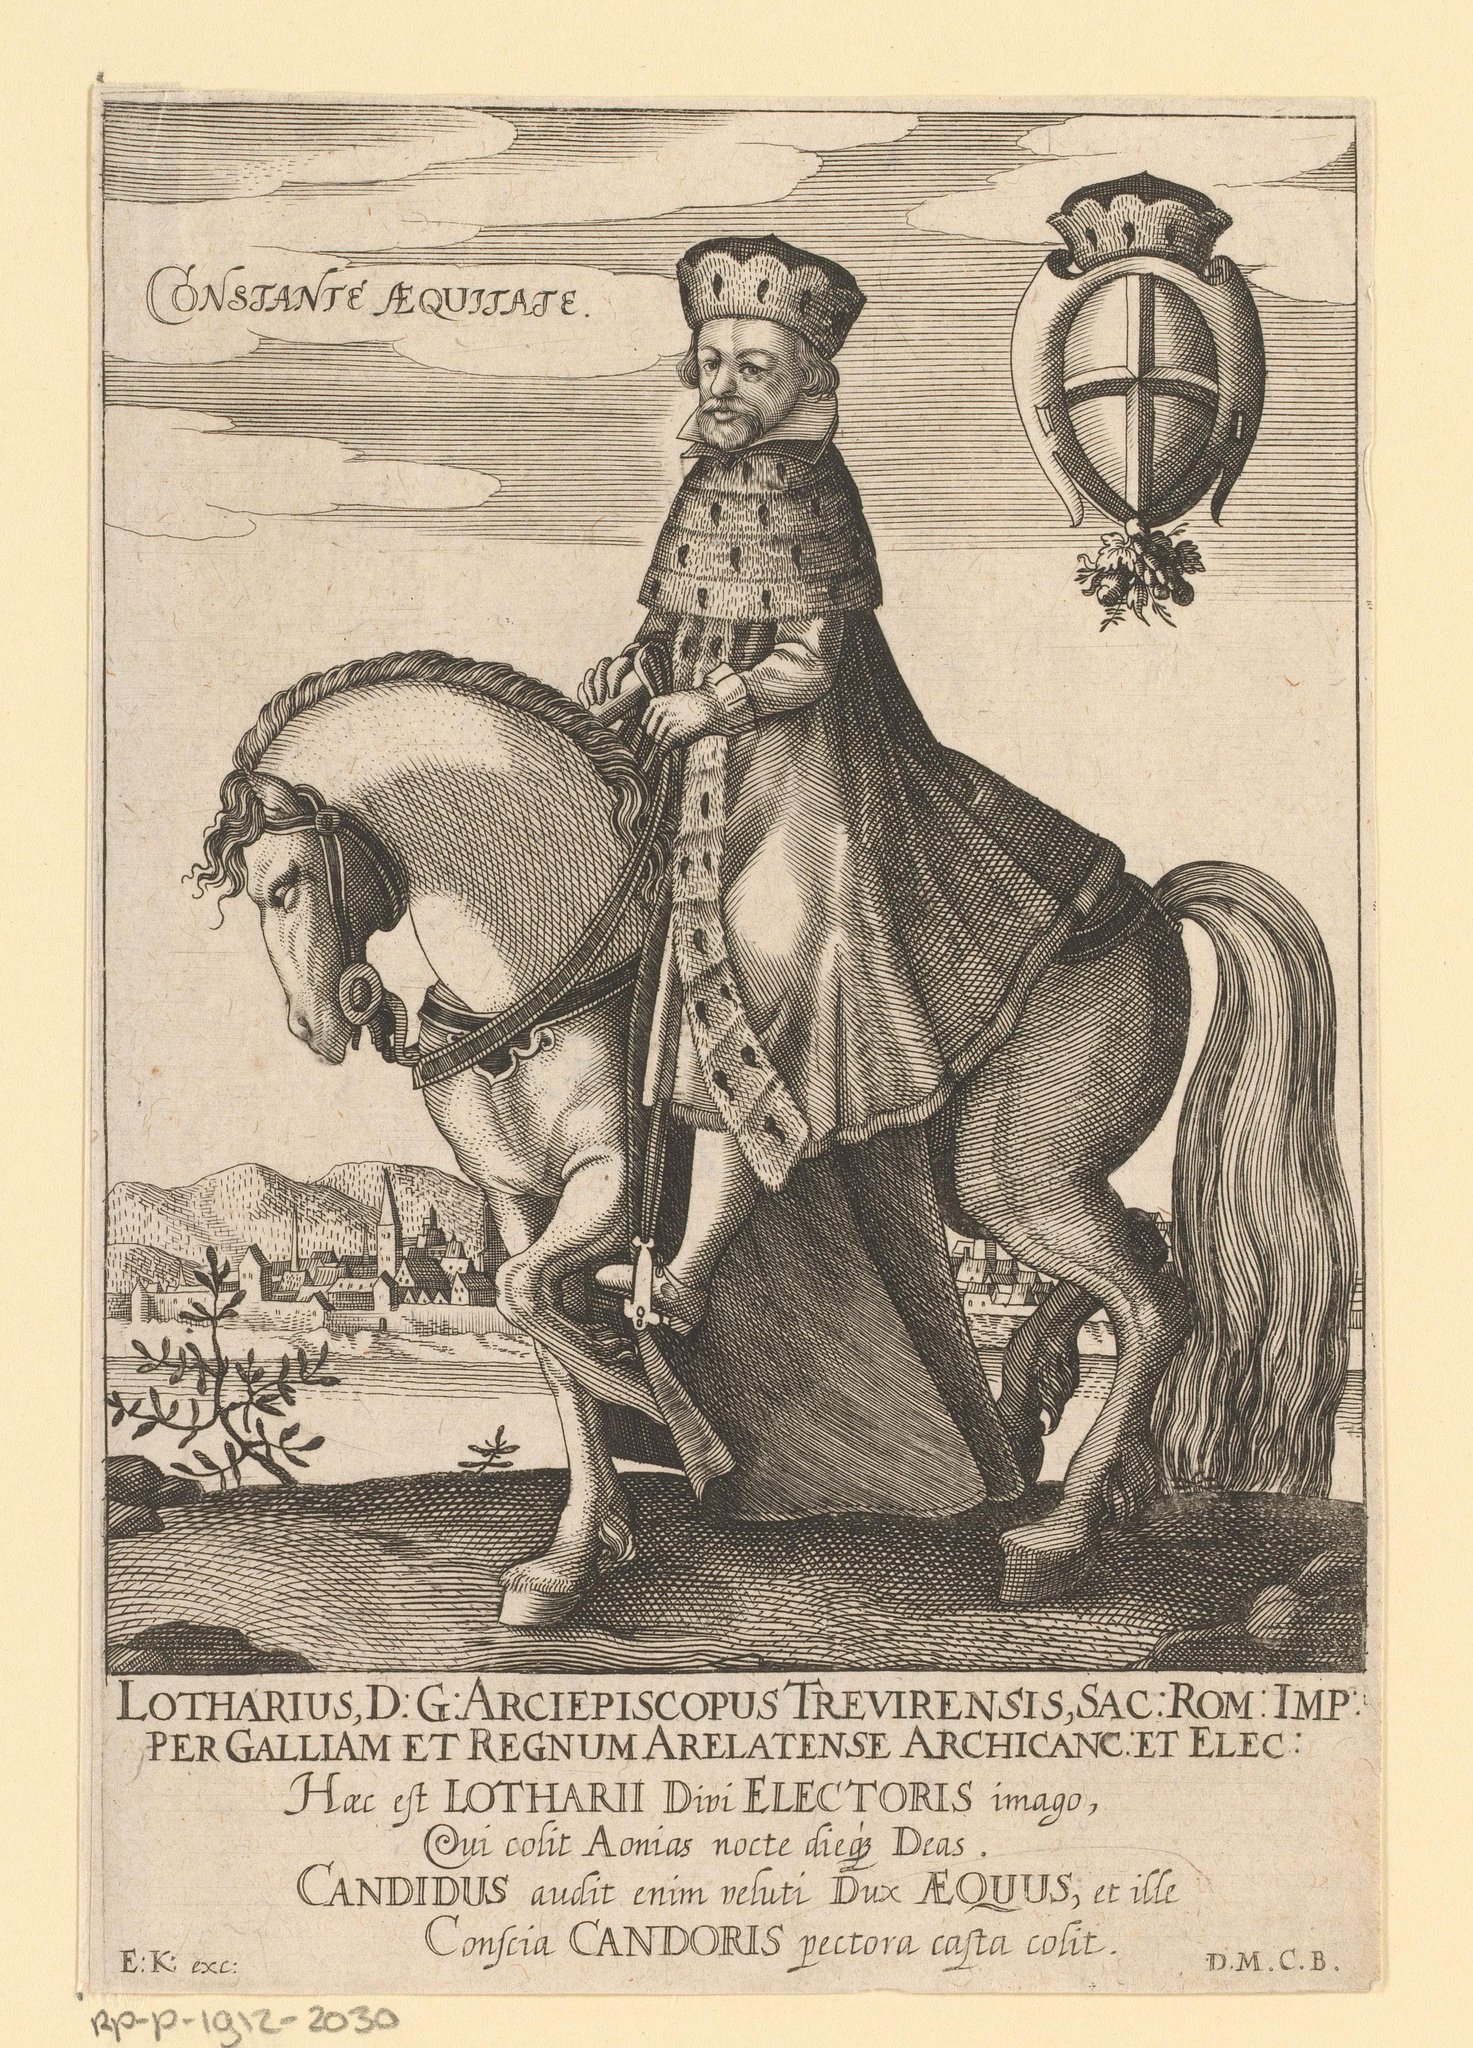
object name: print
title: Lotharius, D:G: Arciepiscopus Trevirensis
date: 1621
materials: paper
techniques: engraving, etching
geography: frankfurt am main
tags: historical persons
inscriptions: collector's mark: Lugt 2228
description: Prent waarschijnlijk uit: Imp. caes. Ferdinandi II p. e. invictavg. p. p. reverediss. sereniss. principvm (...). S.l.s.n., 1621, p. 147.